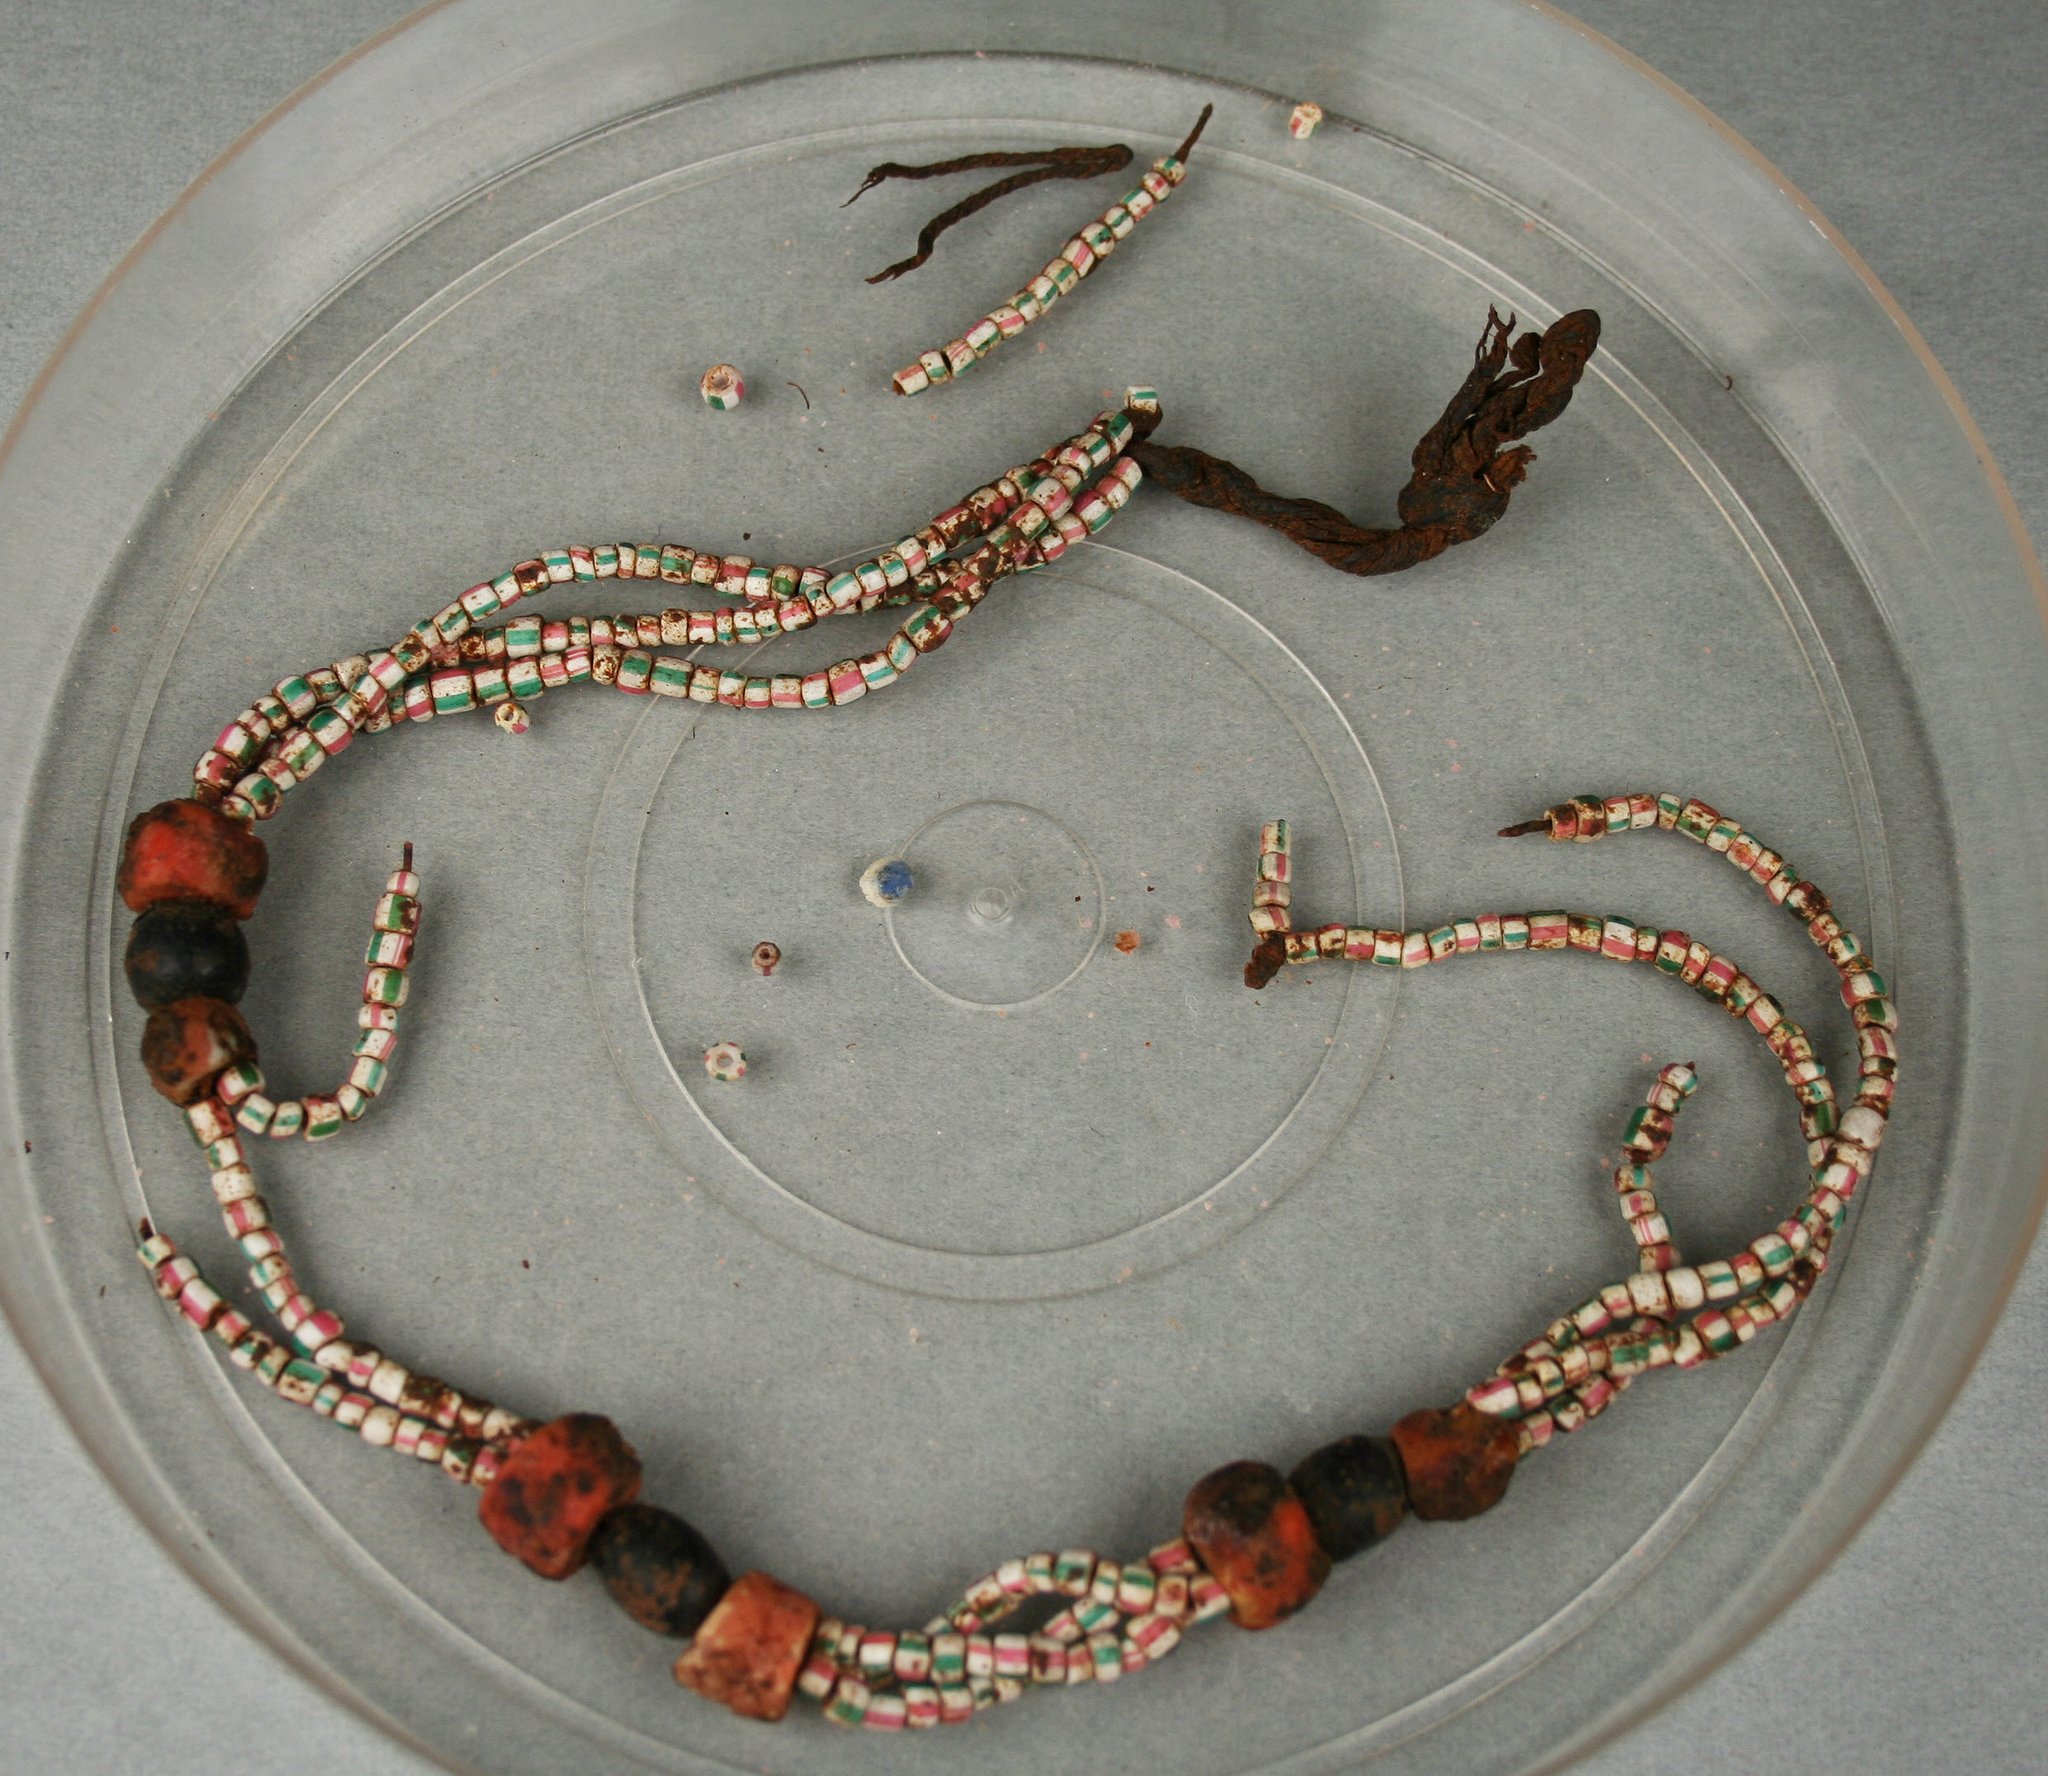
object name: necklace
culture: african or european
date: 1767-1900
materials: gemstone, glass